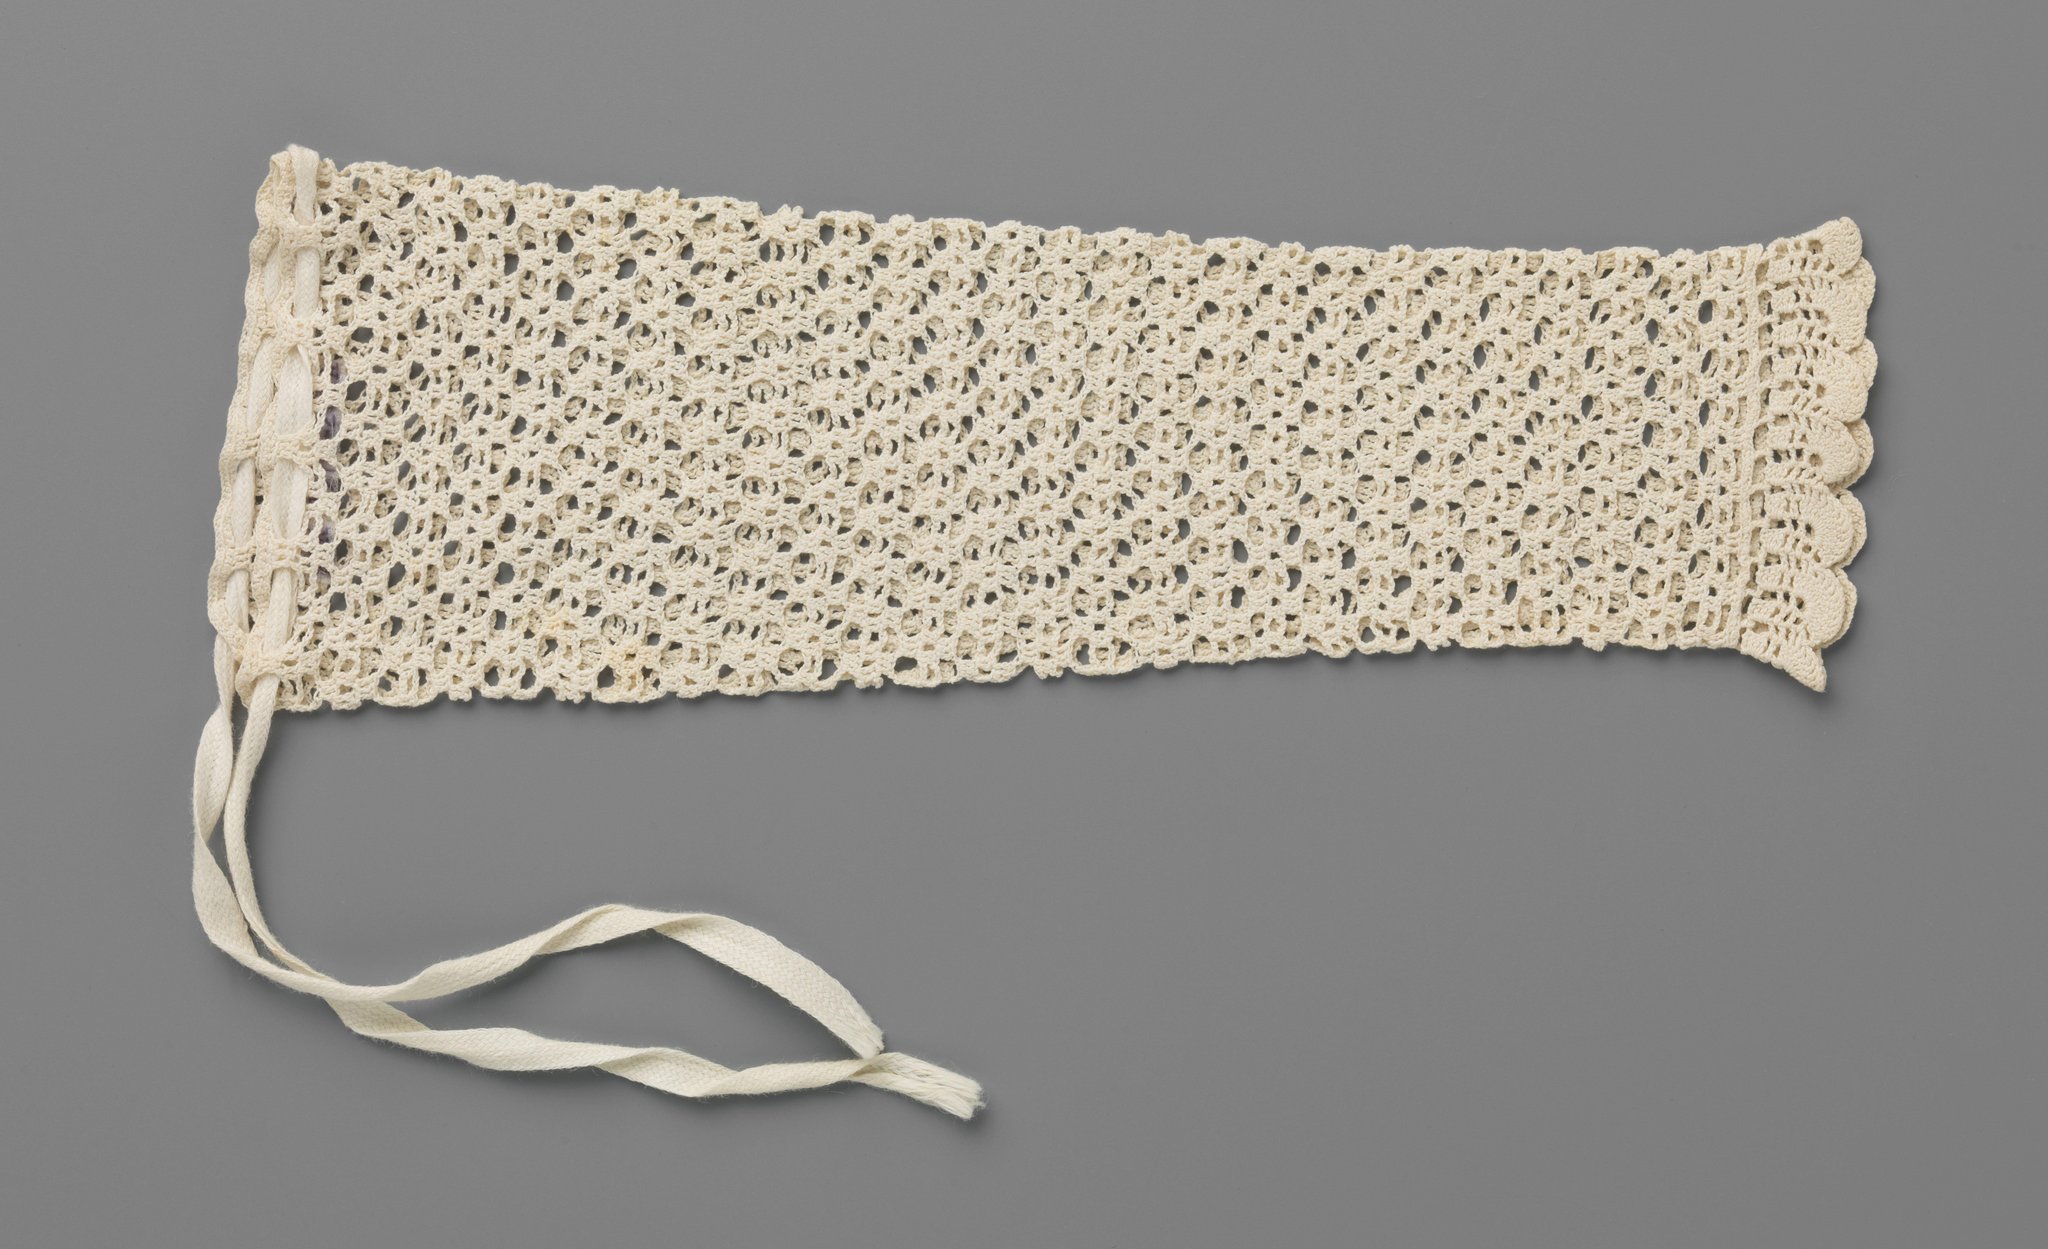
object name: childrenswear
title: Kindermitaine van gehaakte kant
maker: Anonymous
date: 1800-1899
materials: cotton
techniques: crocheted lace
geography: western europe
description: Kindermitaine van naturelkleurige gehaakte kant. Netwerk van rijen opengewerkte cirkeltjes en smalle rechte banen met blokjes en halve cirkeltjes. Iets taps toelopend rechthoekig model. De mitaine kan boven worden vastgesnoerd door middel van een lint.